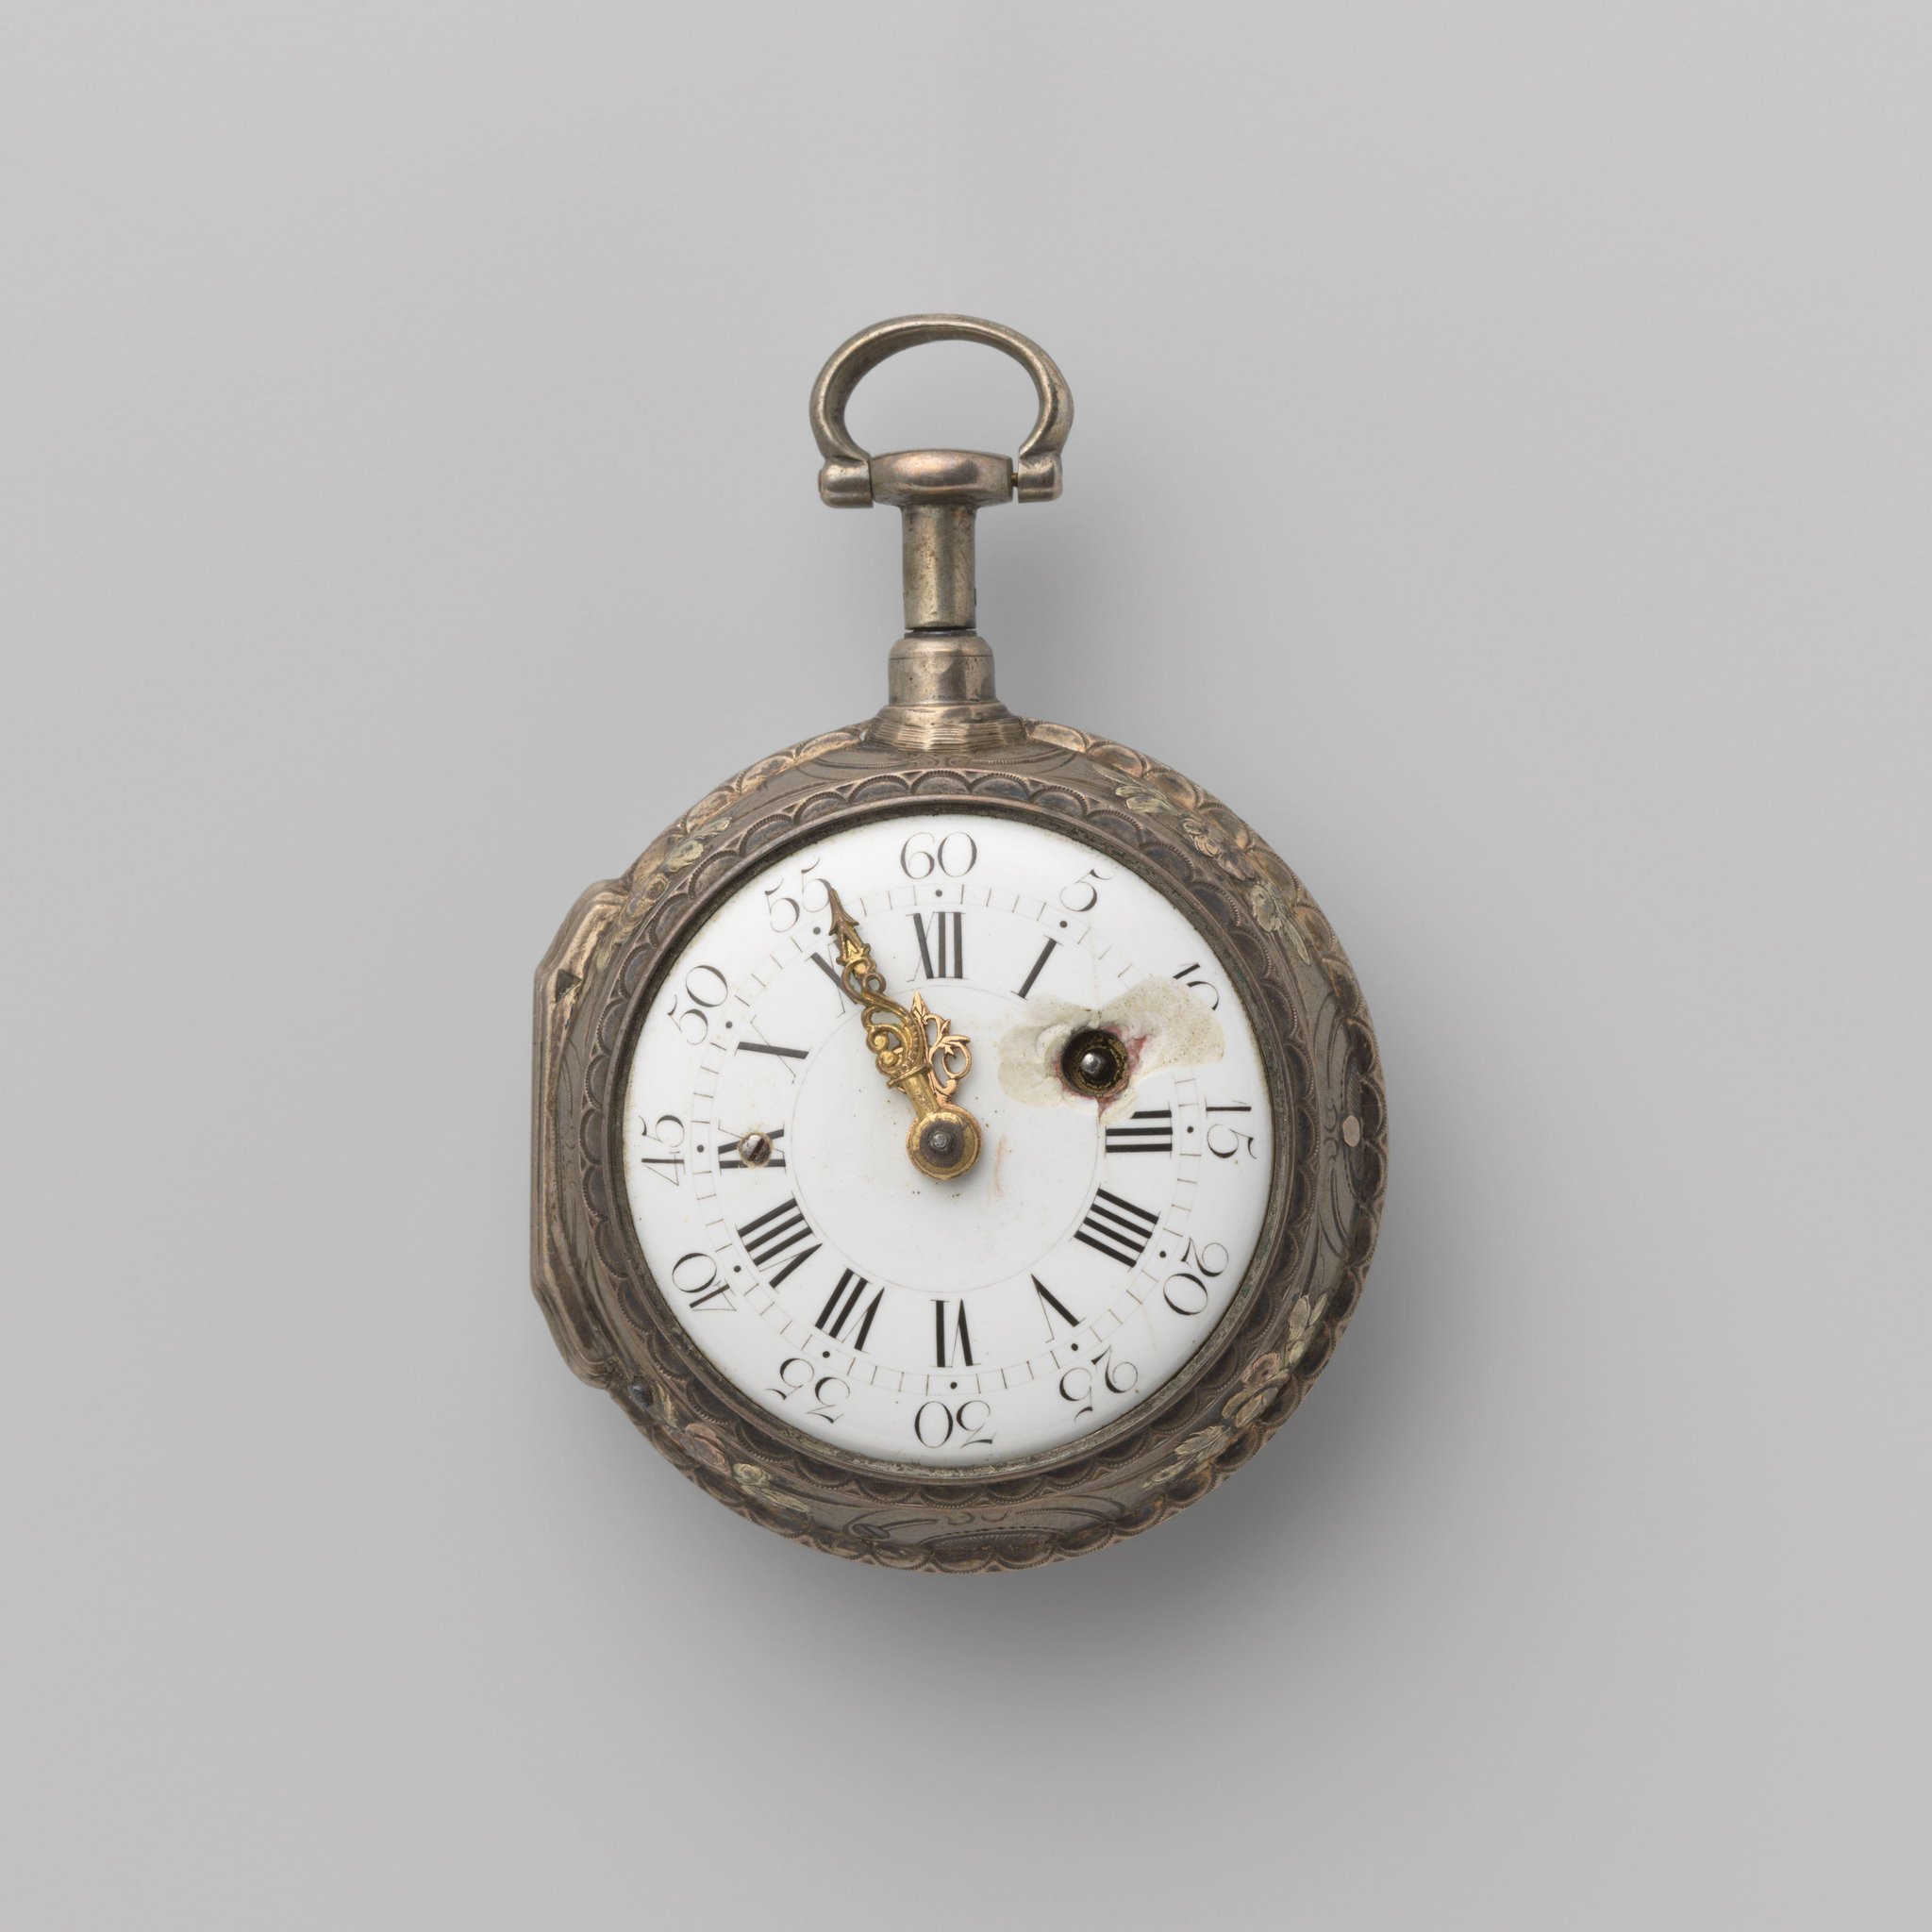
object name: jewellery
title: Horloge van zilver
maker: j.j. henchel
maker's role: clockmaker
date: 1780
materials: glass, silver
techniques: enameling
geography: straatsburg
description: Horloge, repitiehorloge, van zilver. Op de achterbodem een medaillon waarin een monogram van de letters S.L.M.